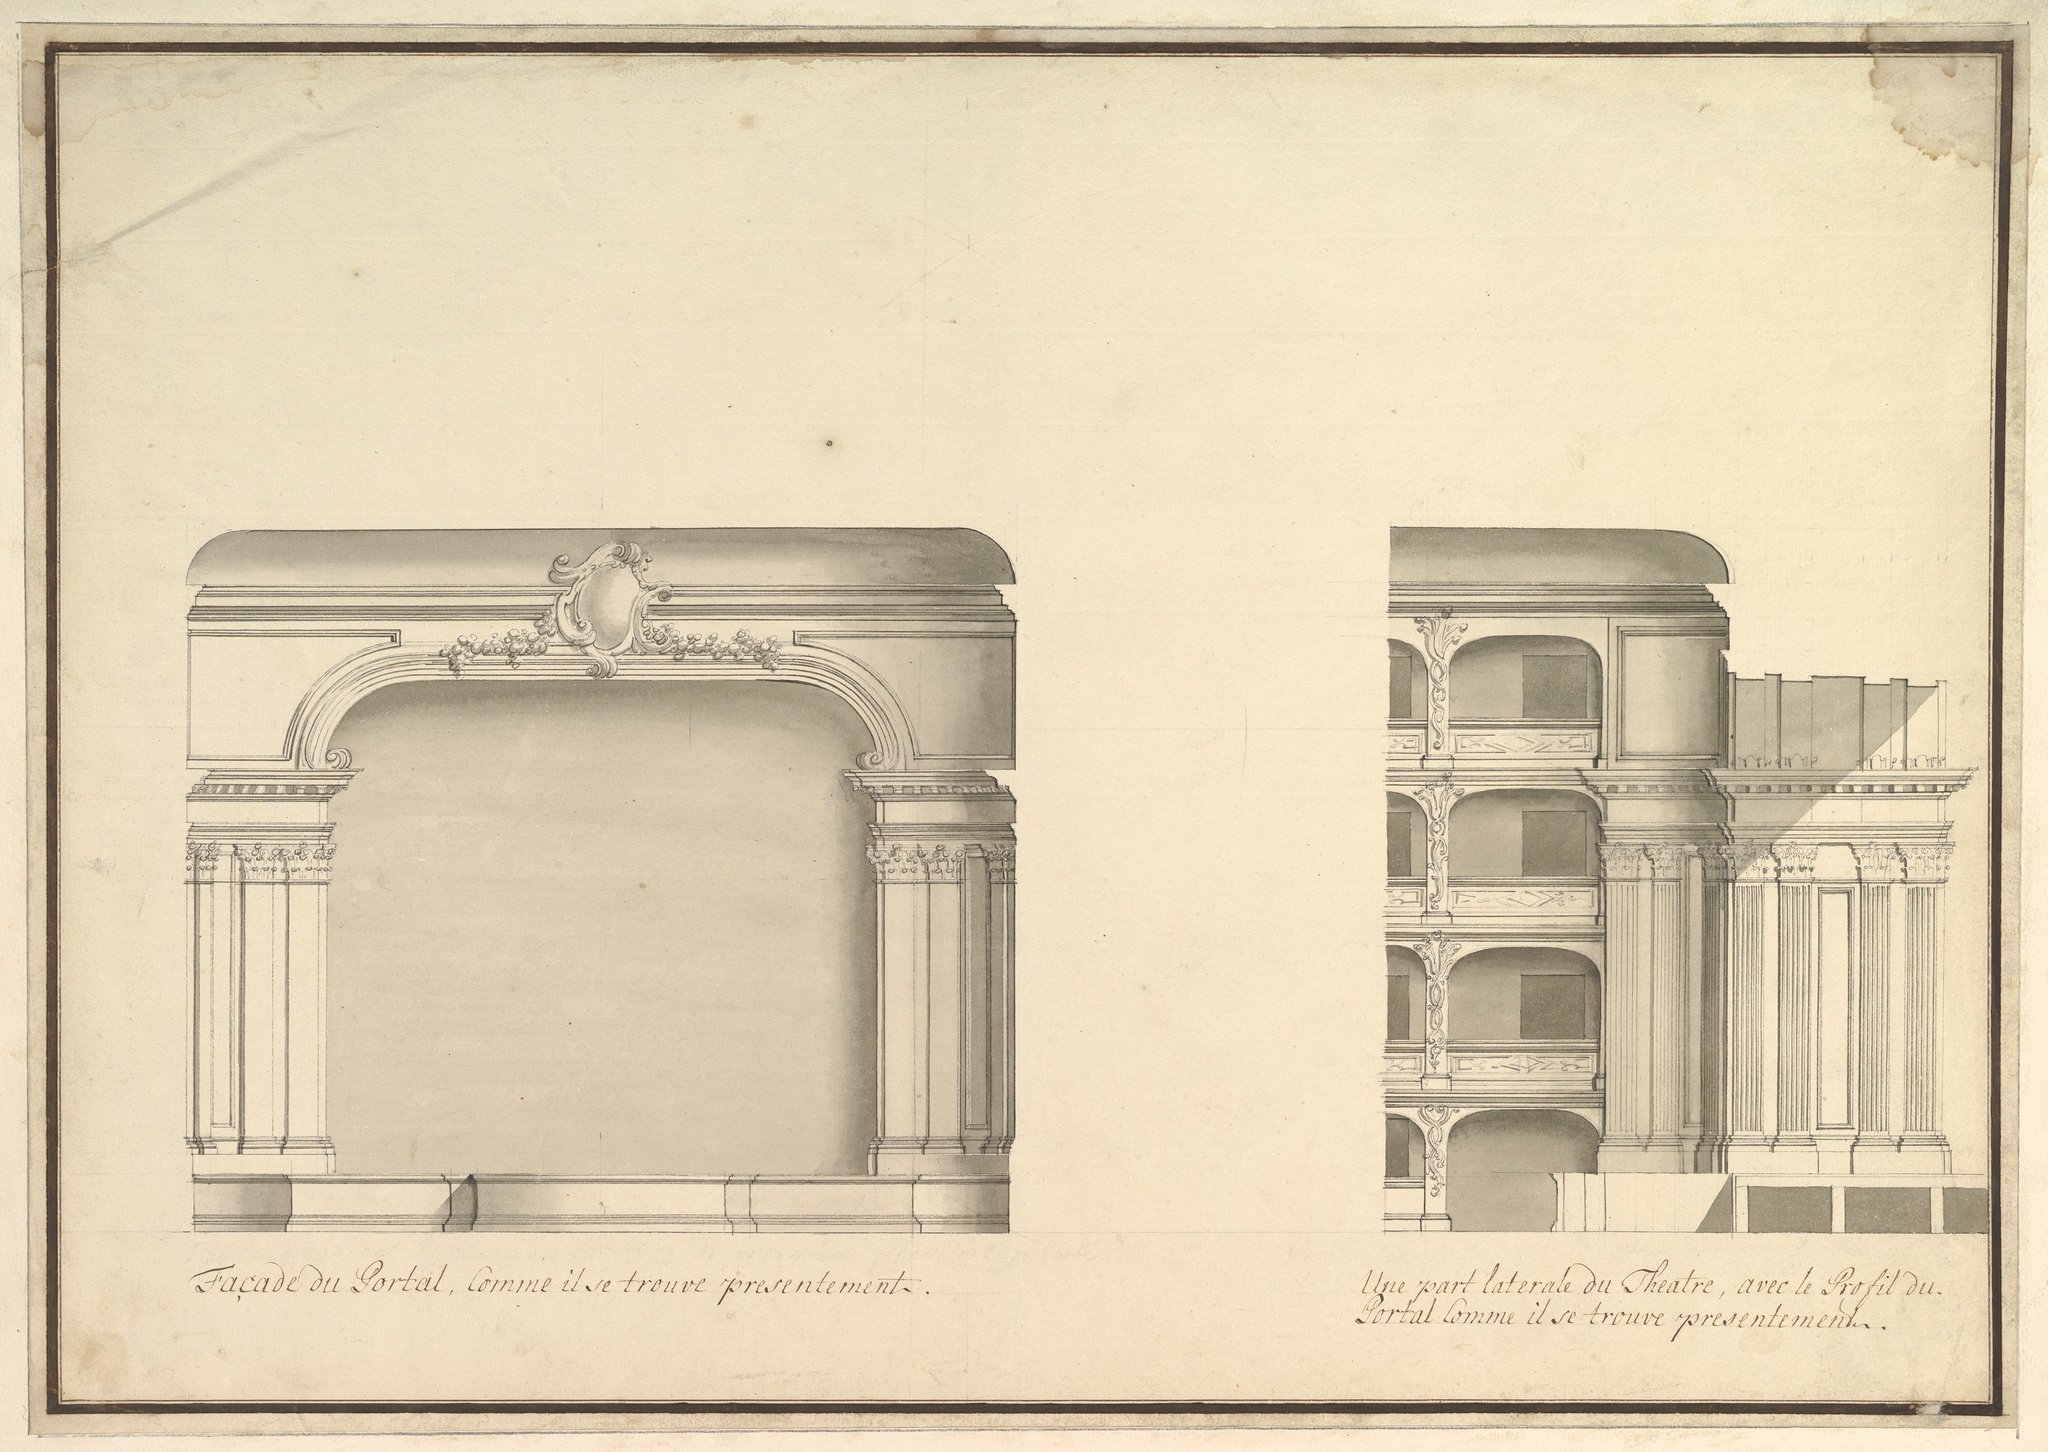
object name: drawing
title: Elevation of Proscenium and Lateral View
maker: giuseppe galli bibiena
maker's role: artist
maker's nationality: italian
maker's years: 1696-1756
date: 1750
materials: graphite, ink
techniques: pen, wash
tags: architecture